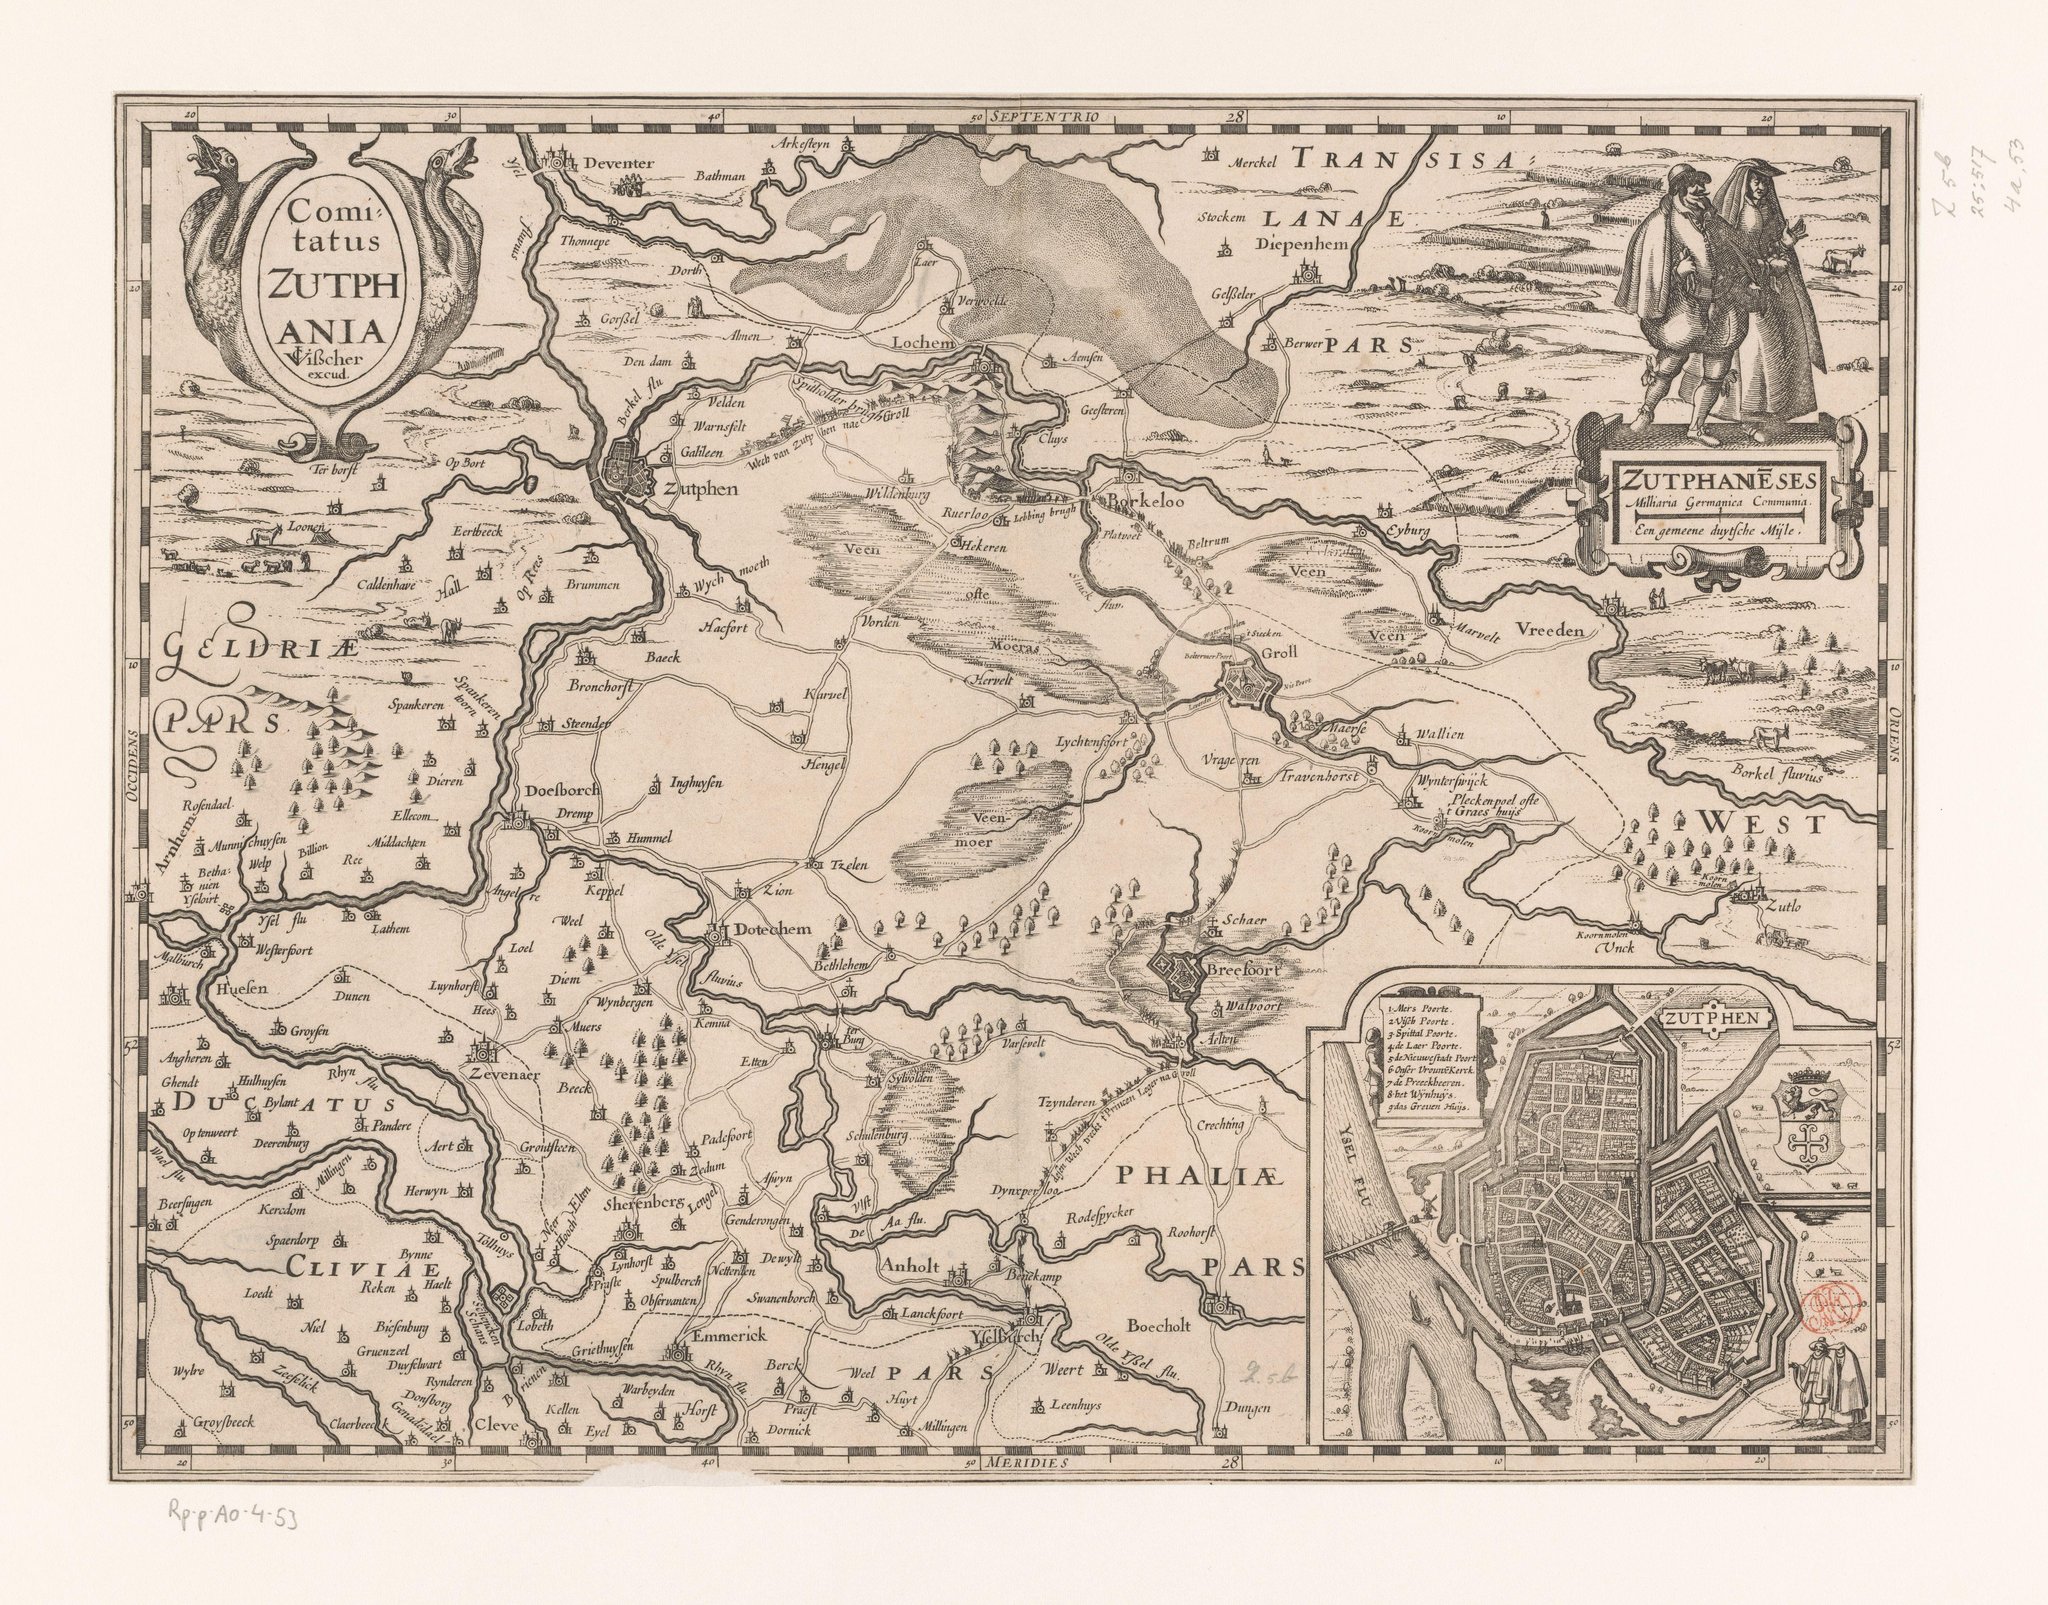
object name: map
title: Kaart van het graafschap Zutphen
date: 1617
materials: paper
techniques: engraving, etching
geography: amsterdam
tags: maps of separate countries or regions, maps of cities, gelderland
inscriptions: collector's mark: Lugt 195, collector's mark: Lugt 2228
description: Linksboven de titelcartouche. Rechtsboven een cartouche met schaalstok: 2 Milliaria Germanica Communia. Rechtsonder een plattegrond van Zutphen, met rechts het stadswapen. De kaart is voorzien van een gradenverdeling langs de randen.